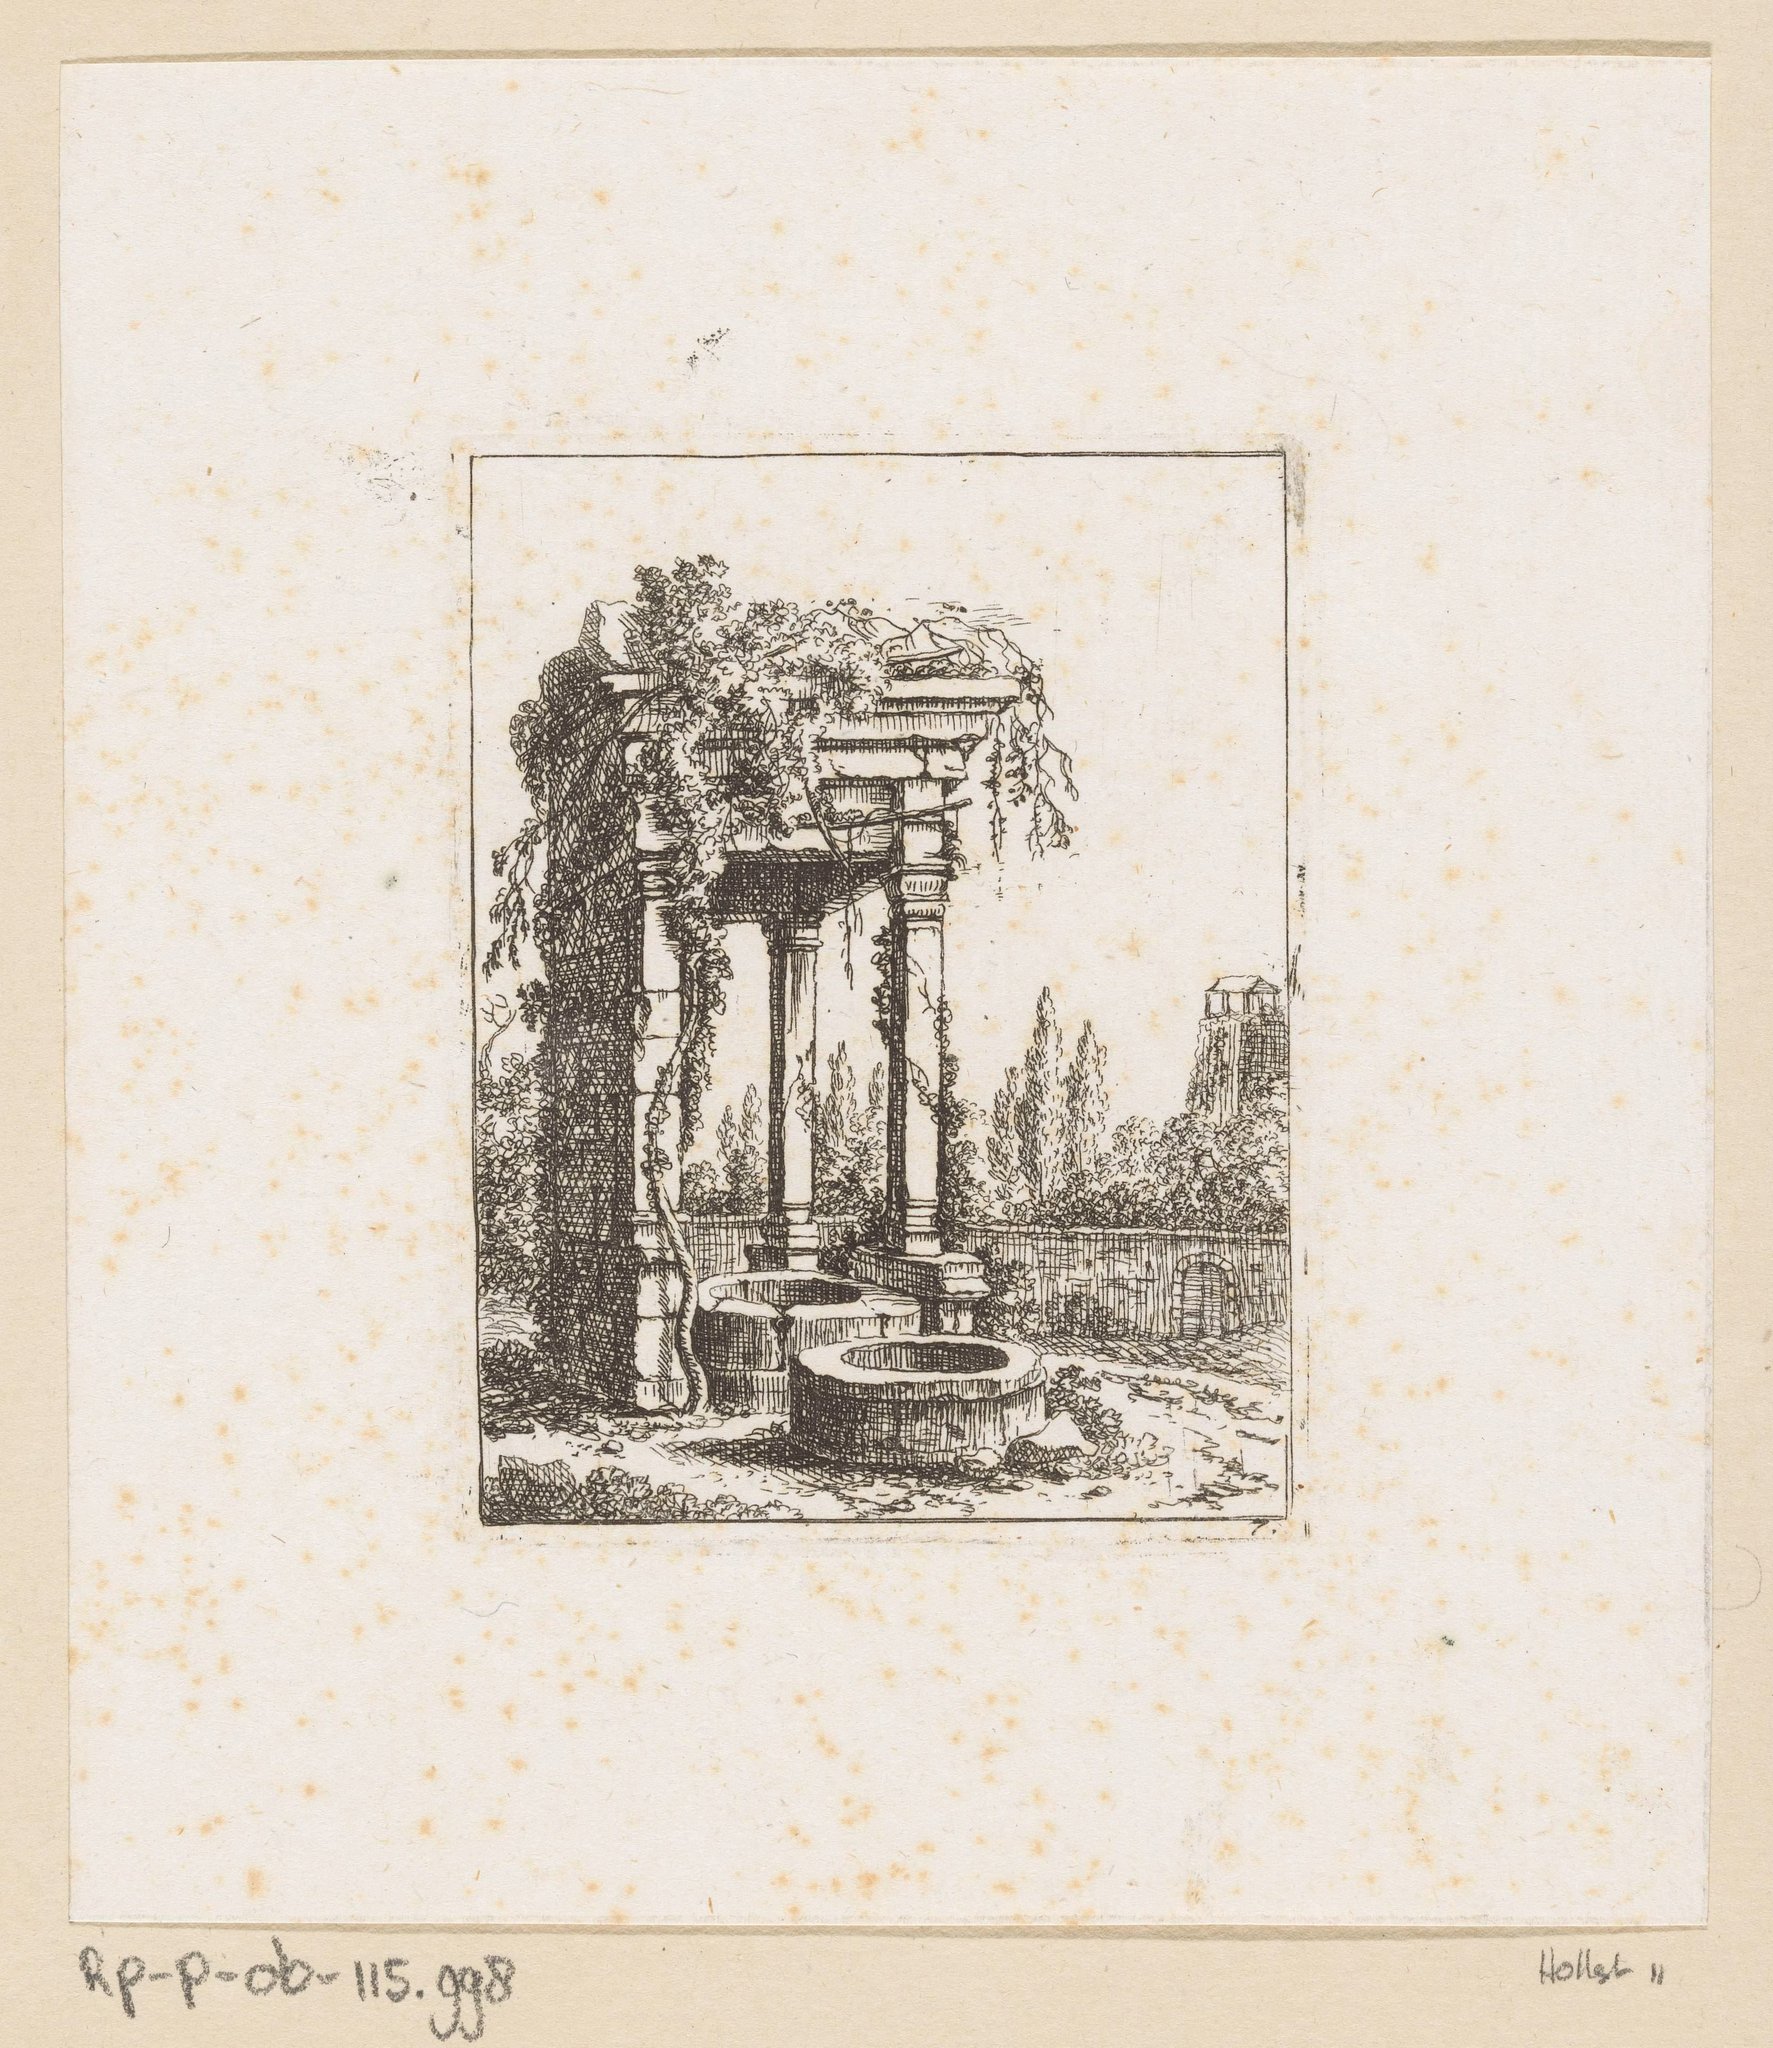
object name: print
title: Romeinse ruïnes en monumenten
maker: johann franz ermels (der ältere)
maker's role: draughtsman, print maker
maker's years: 1641-1693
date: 1651-1693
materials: paper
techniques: etching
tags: well, landscape with ruins, rome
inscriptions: collector's mark: Lugt 240